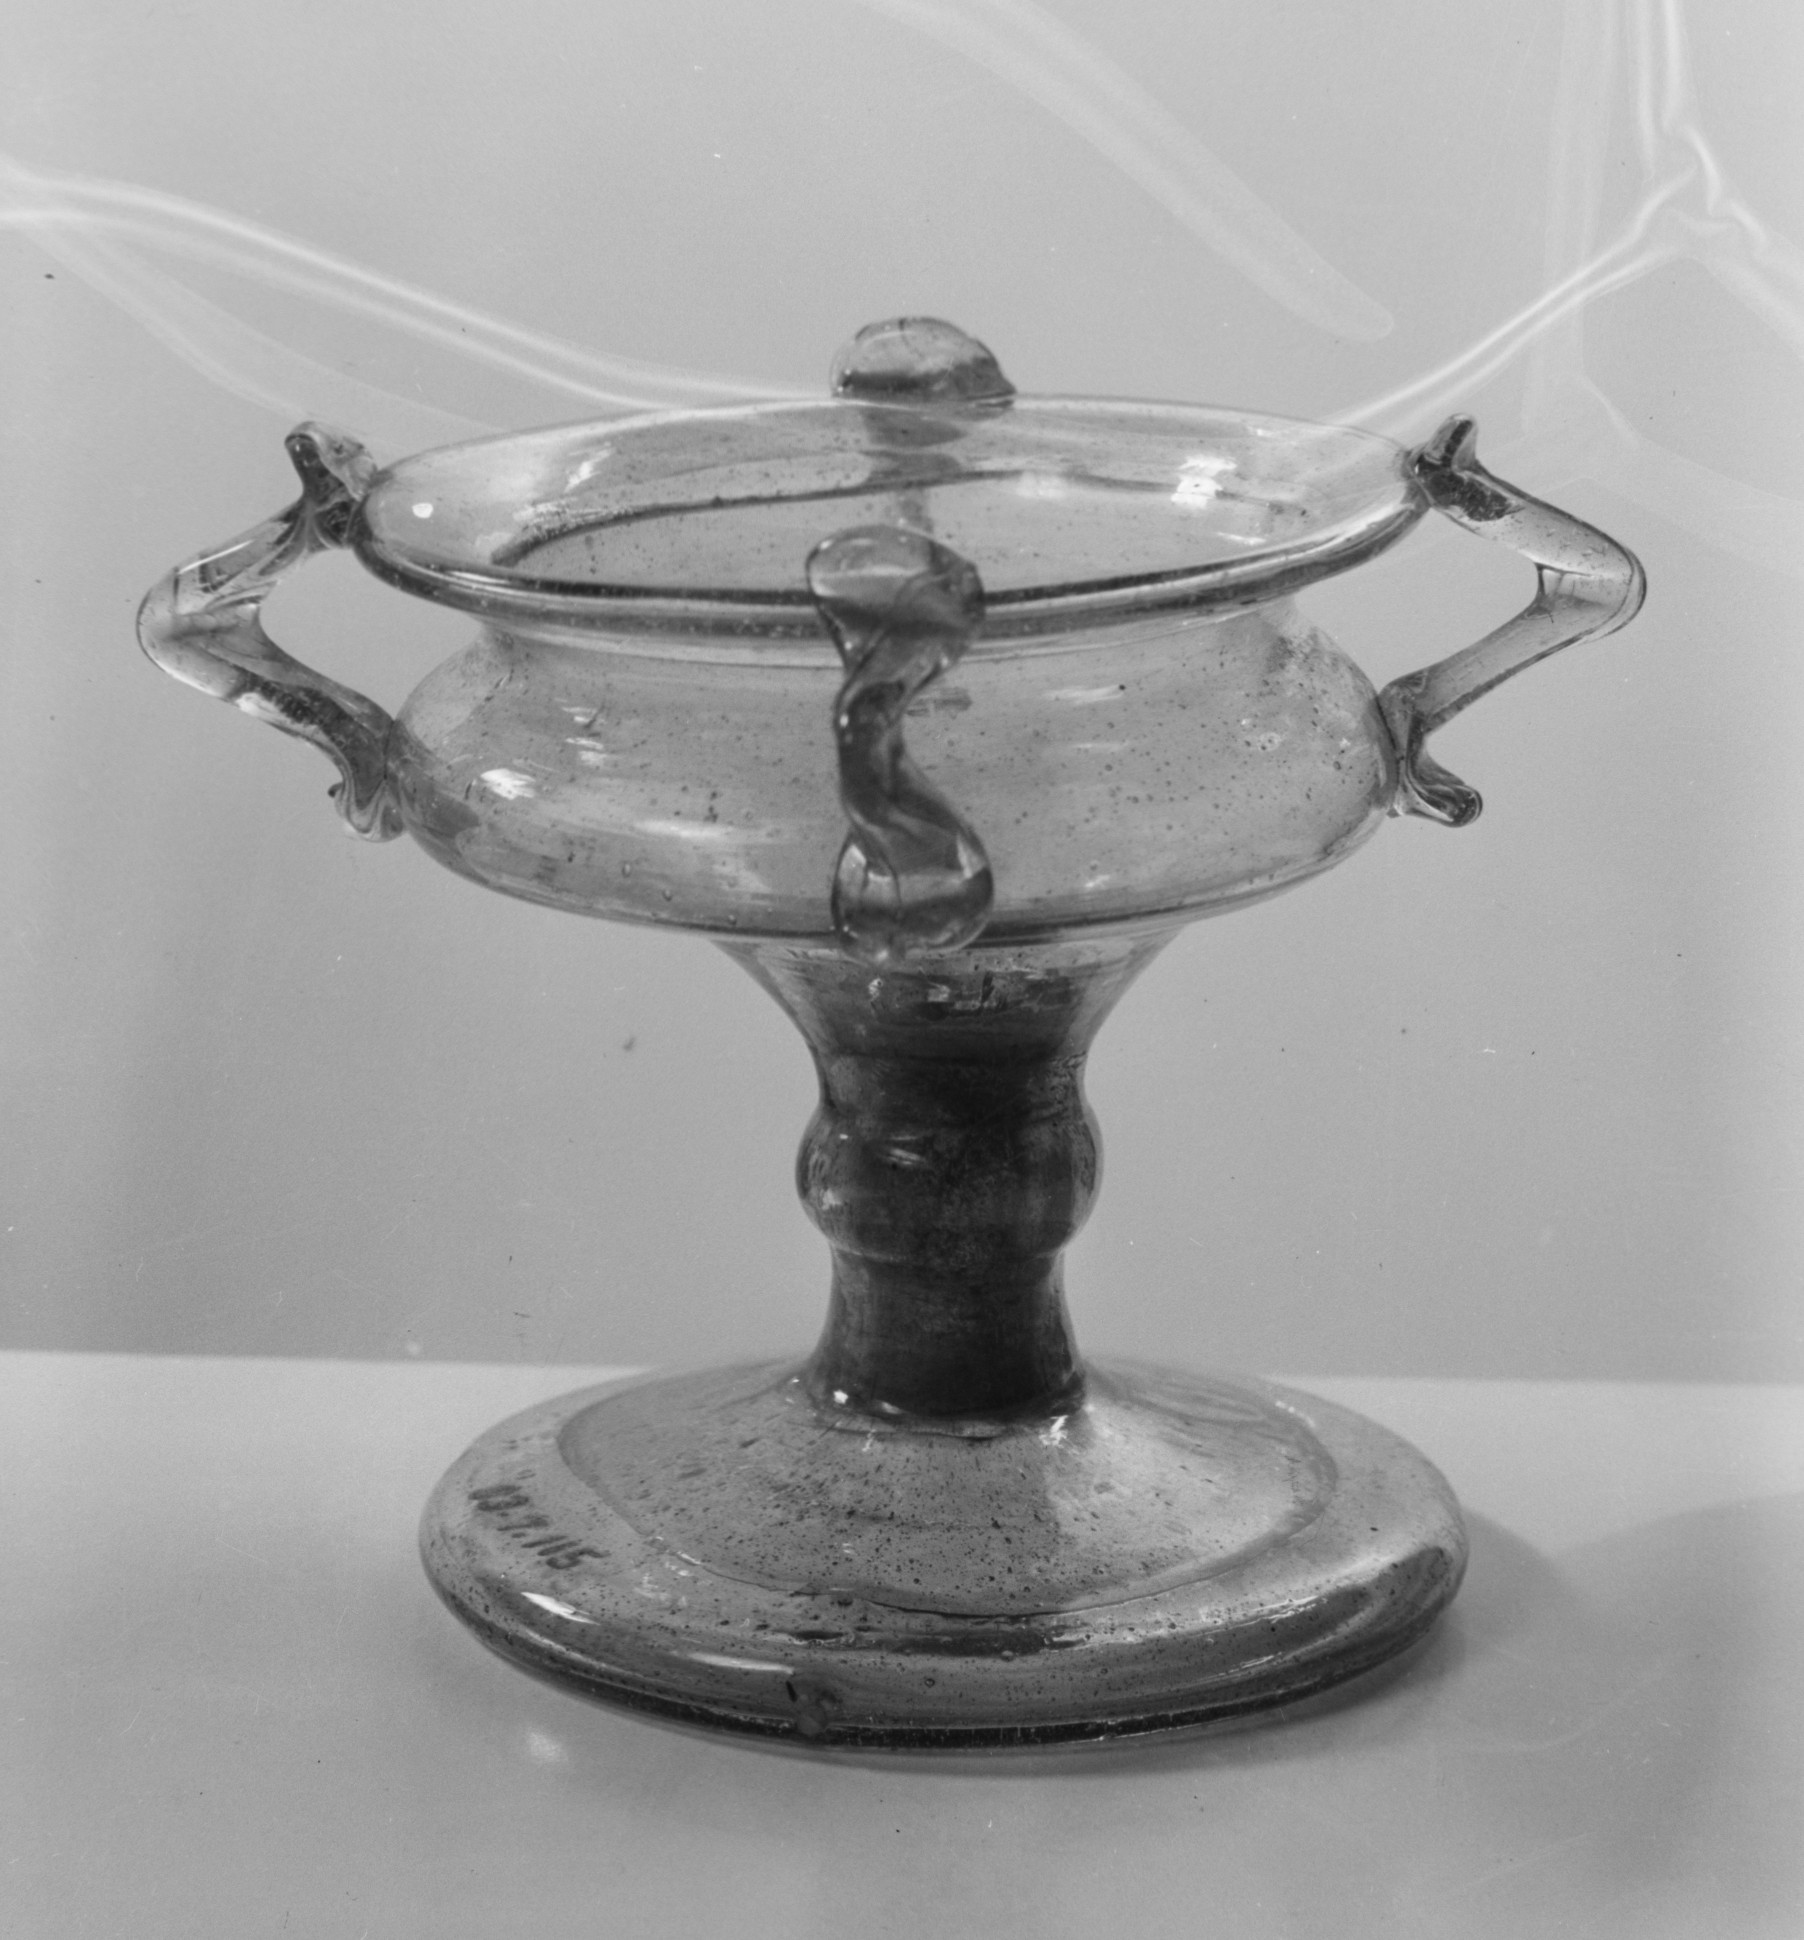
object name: saltcellar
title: Saltcellar (?)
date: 1701-1800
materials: glass